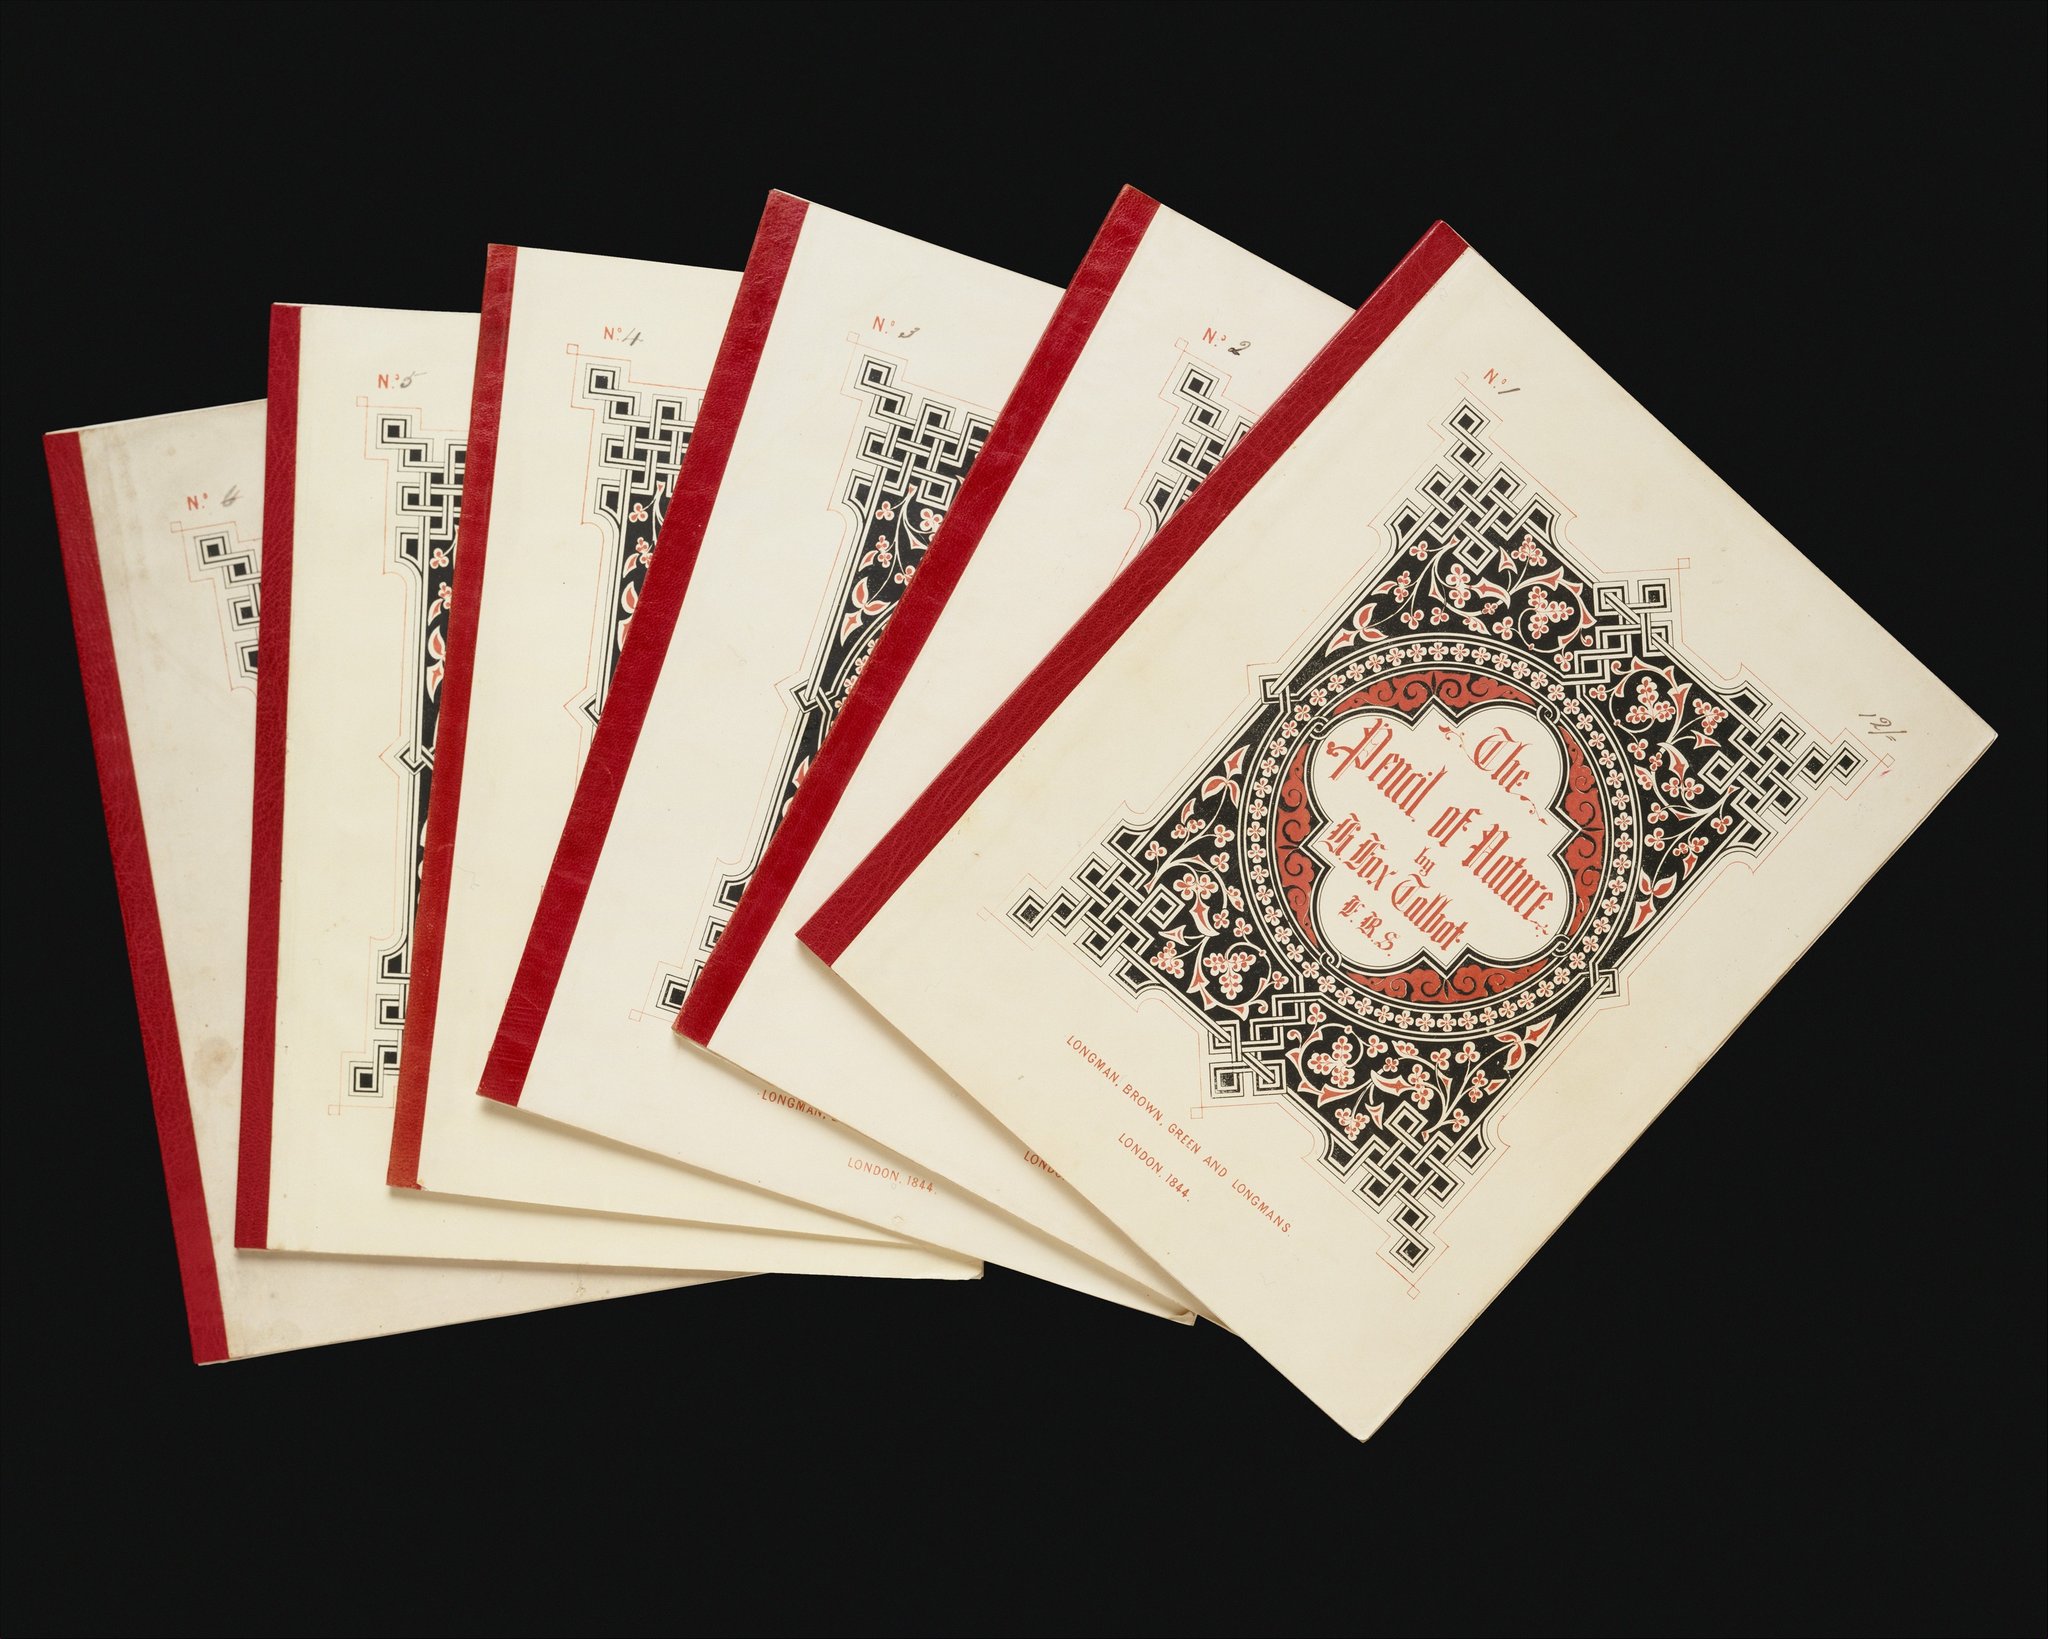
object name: photographically illustrated book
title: The Pencil of Nature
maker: william henry fox talbot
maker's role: artist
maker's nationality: british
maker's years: 1800-1877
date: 1844-1846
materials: paper, photographic print